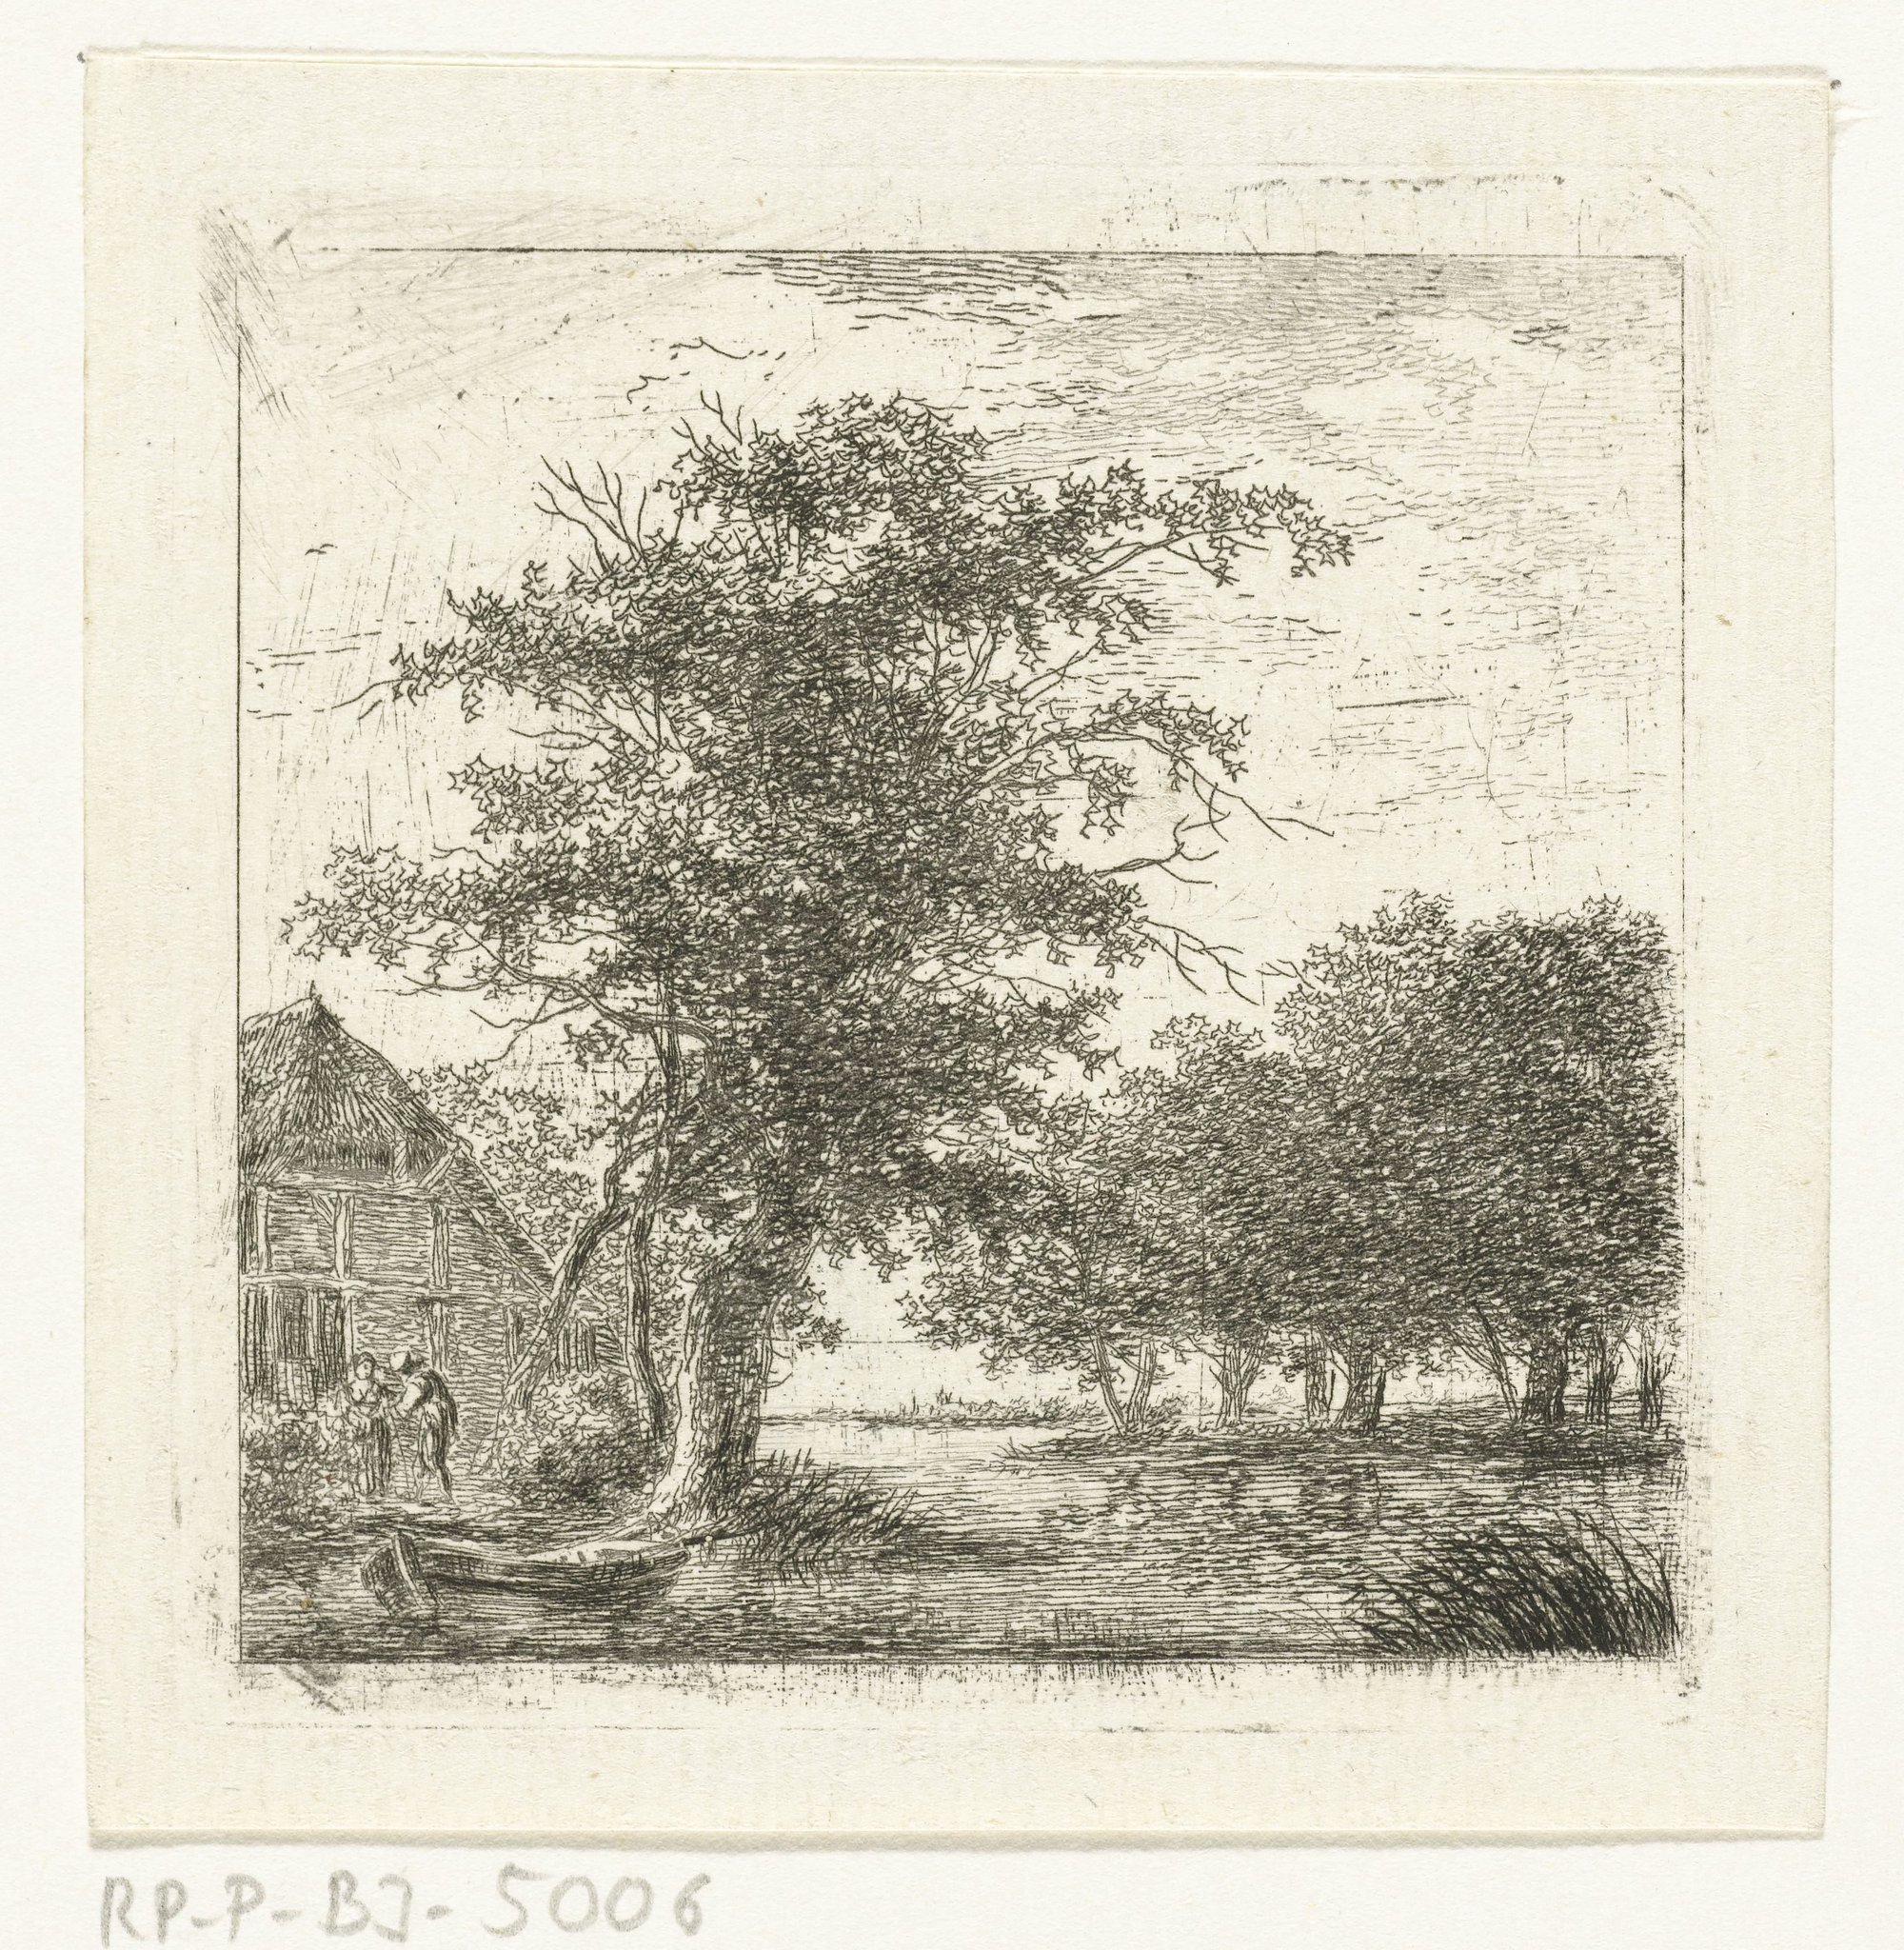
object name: print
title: Rivier in boomrijk landschap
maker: hermanus van brussel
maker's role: draughtsman, print maker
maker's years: 1763-1815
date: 1800-1815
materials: paper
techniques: etching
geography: netherlands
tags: landscapes in the temperate zone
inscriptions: collector's mark: Lugt 2228